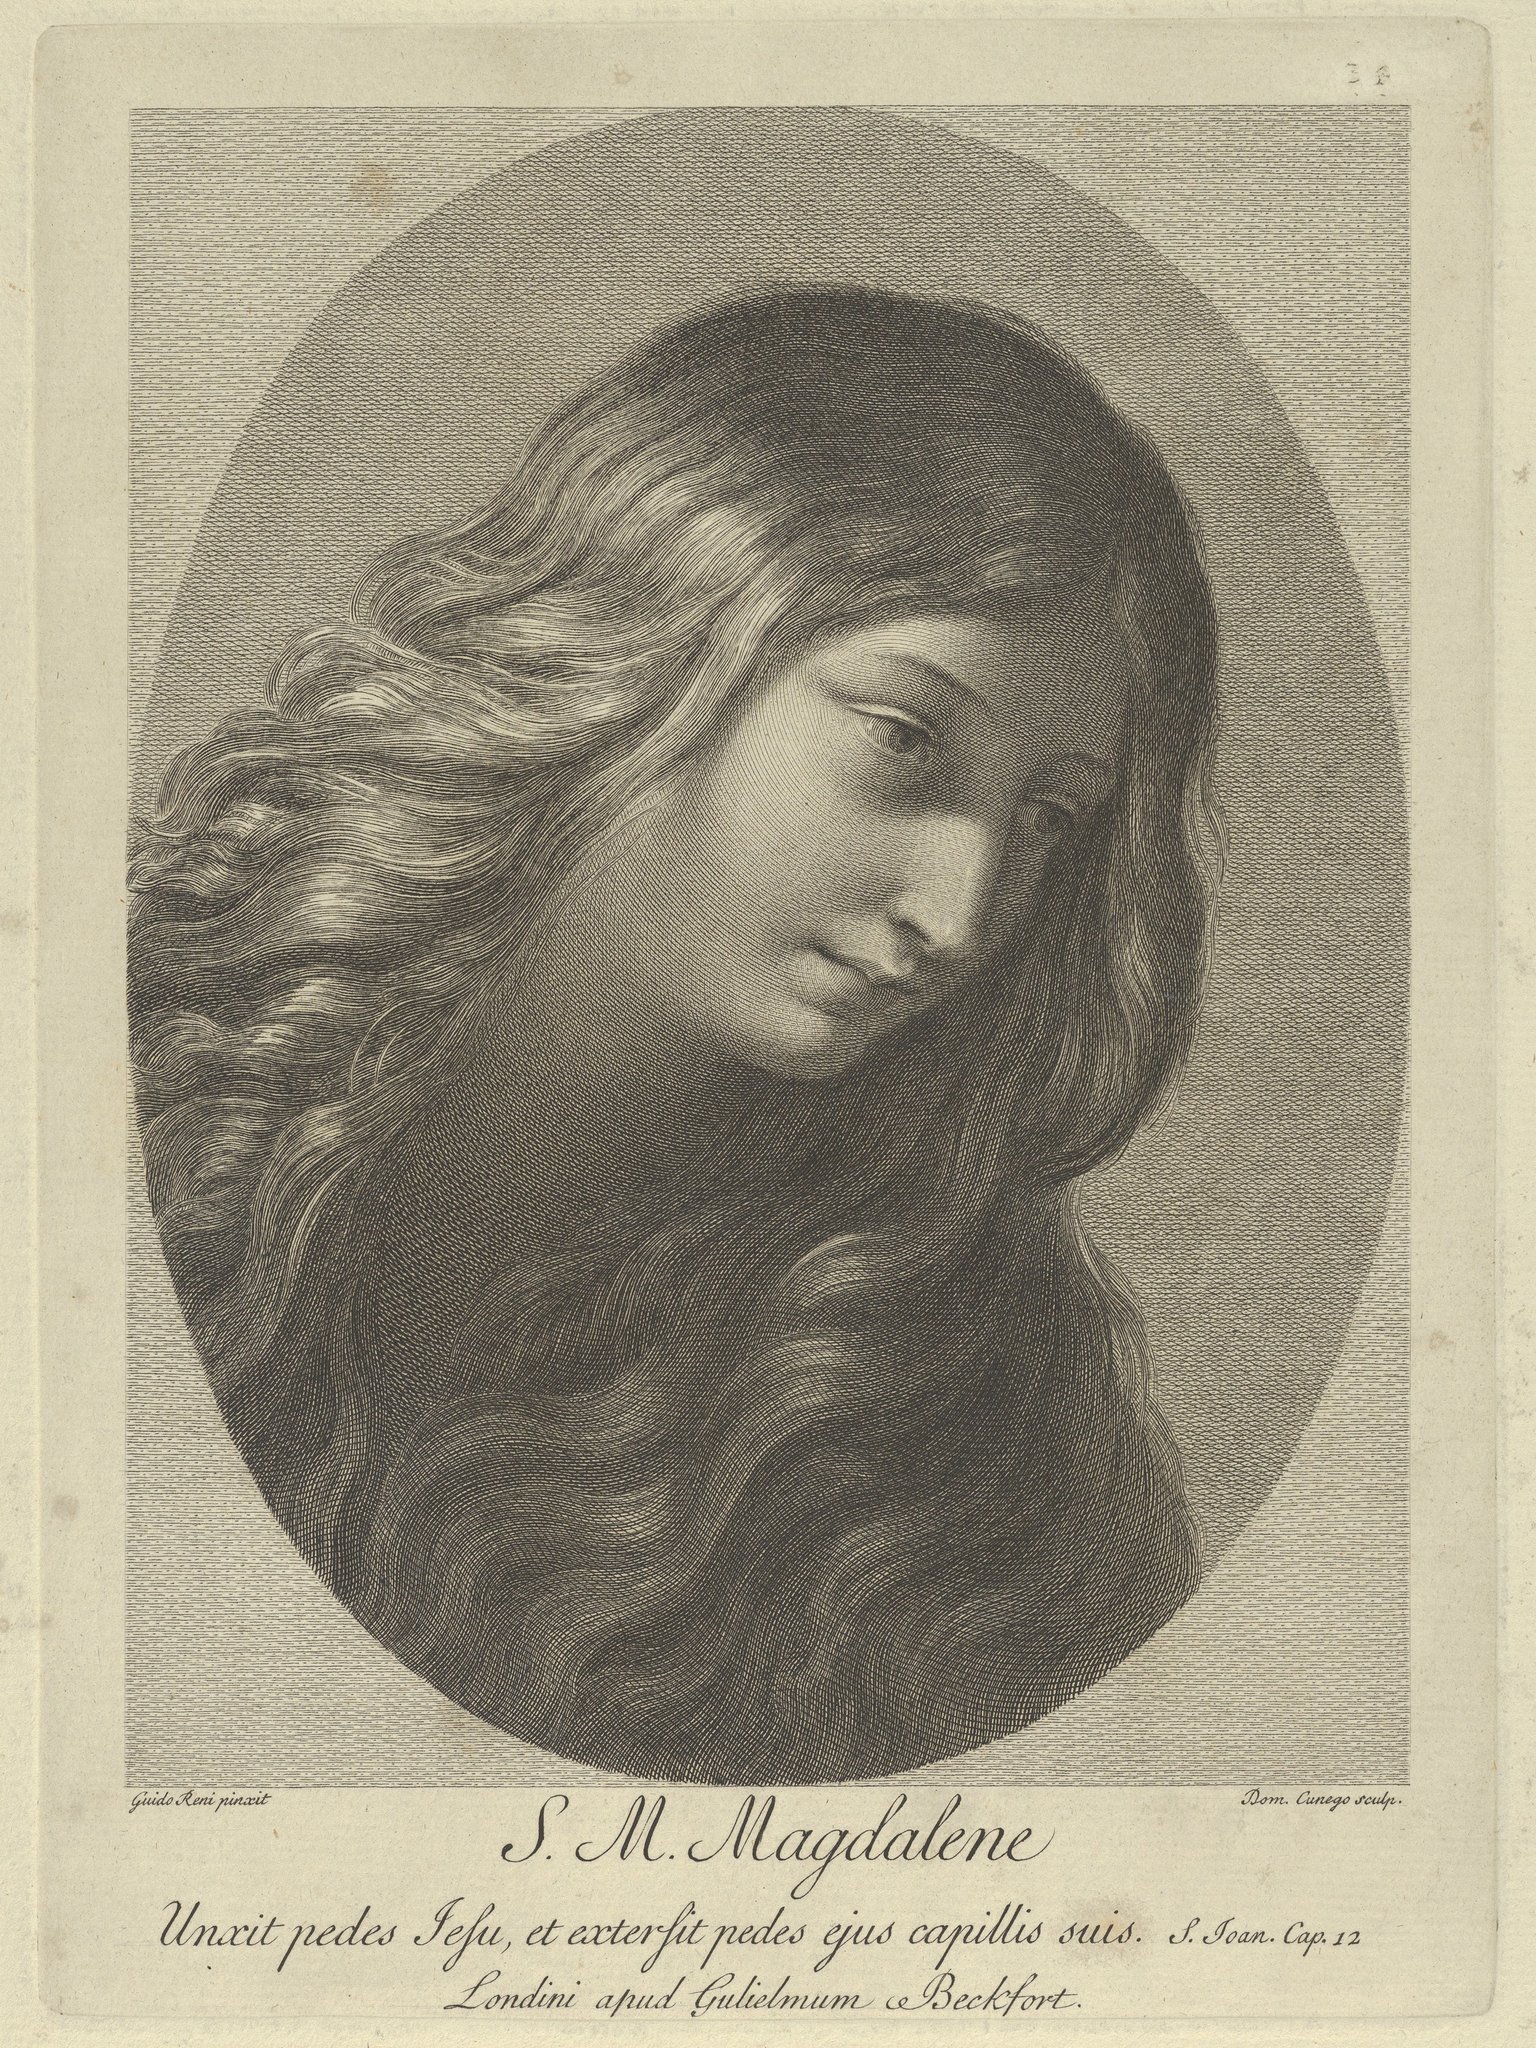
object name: print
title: The head of Mary Magdalene looking down to the right, after Reni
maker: domenico cunego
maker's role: engraver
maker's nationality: italian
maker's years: 1727-1803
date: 1745-1803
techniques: engraving, etching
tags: portraits,mary magdalene